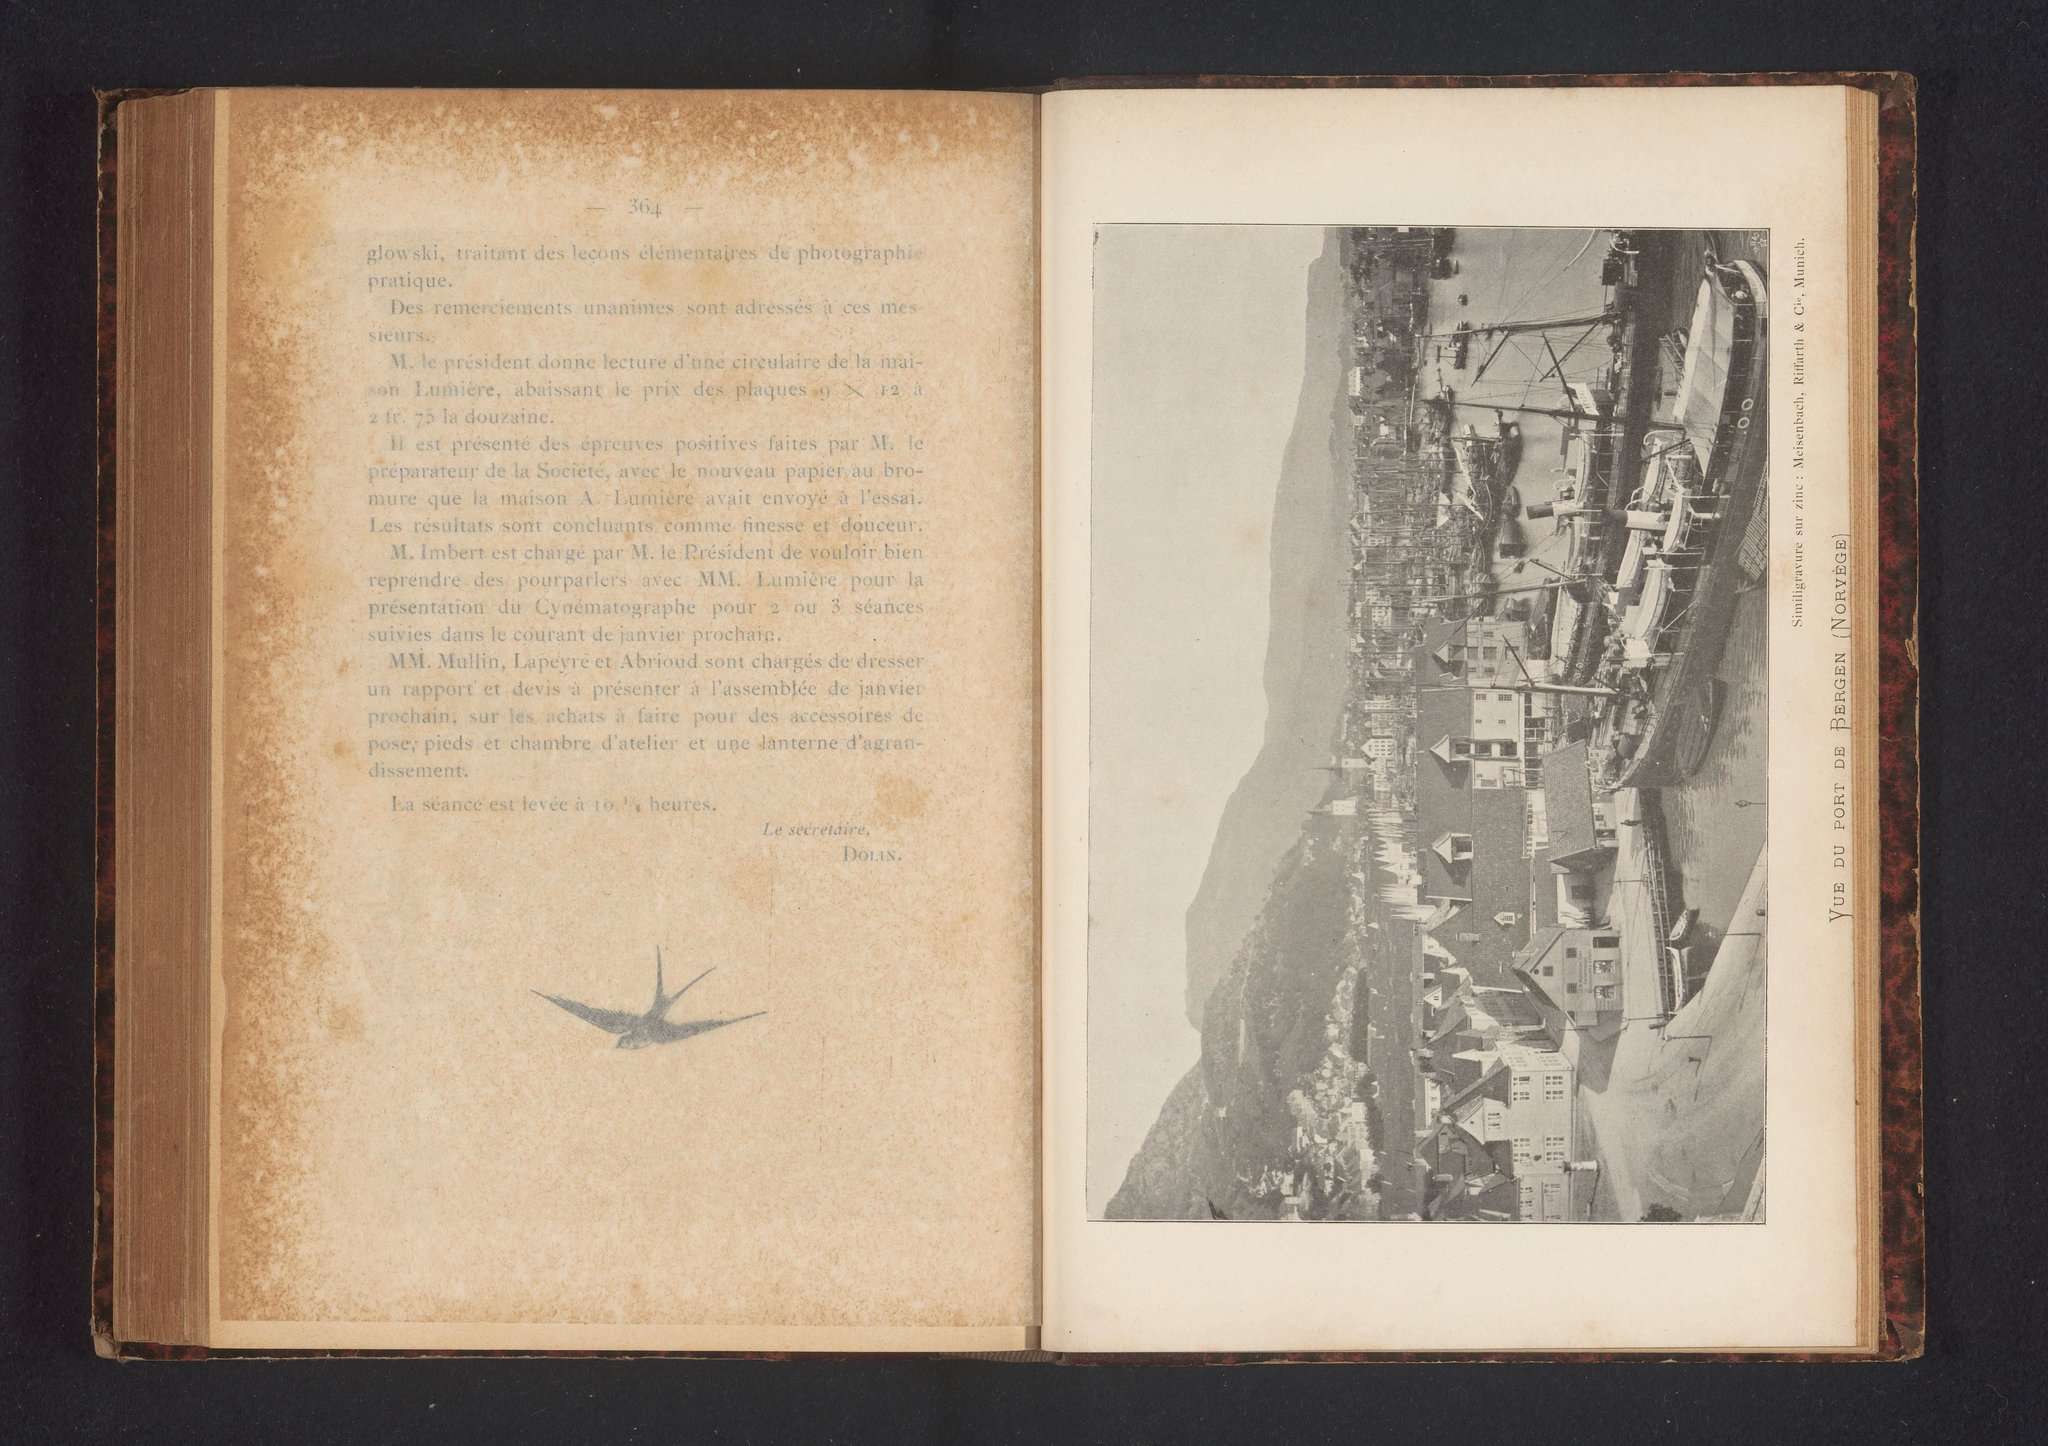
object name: page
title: Vue du port de Bergen (Norvège)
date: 1891-1896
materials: paper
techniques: autotype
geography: bergen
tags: harbour